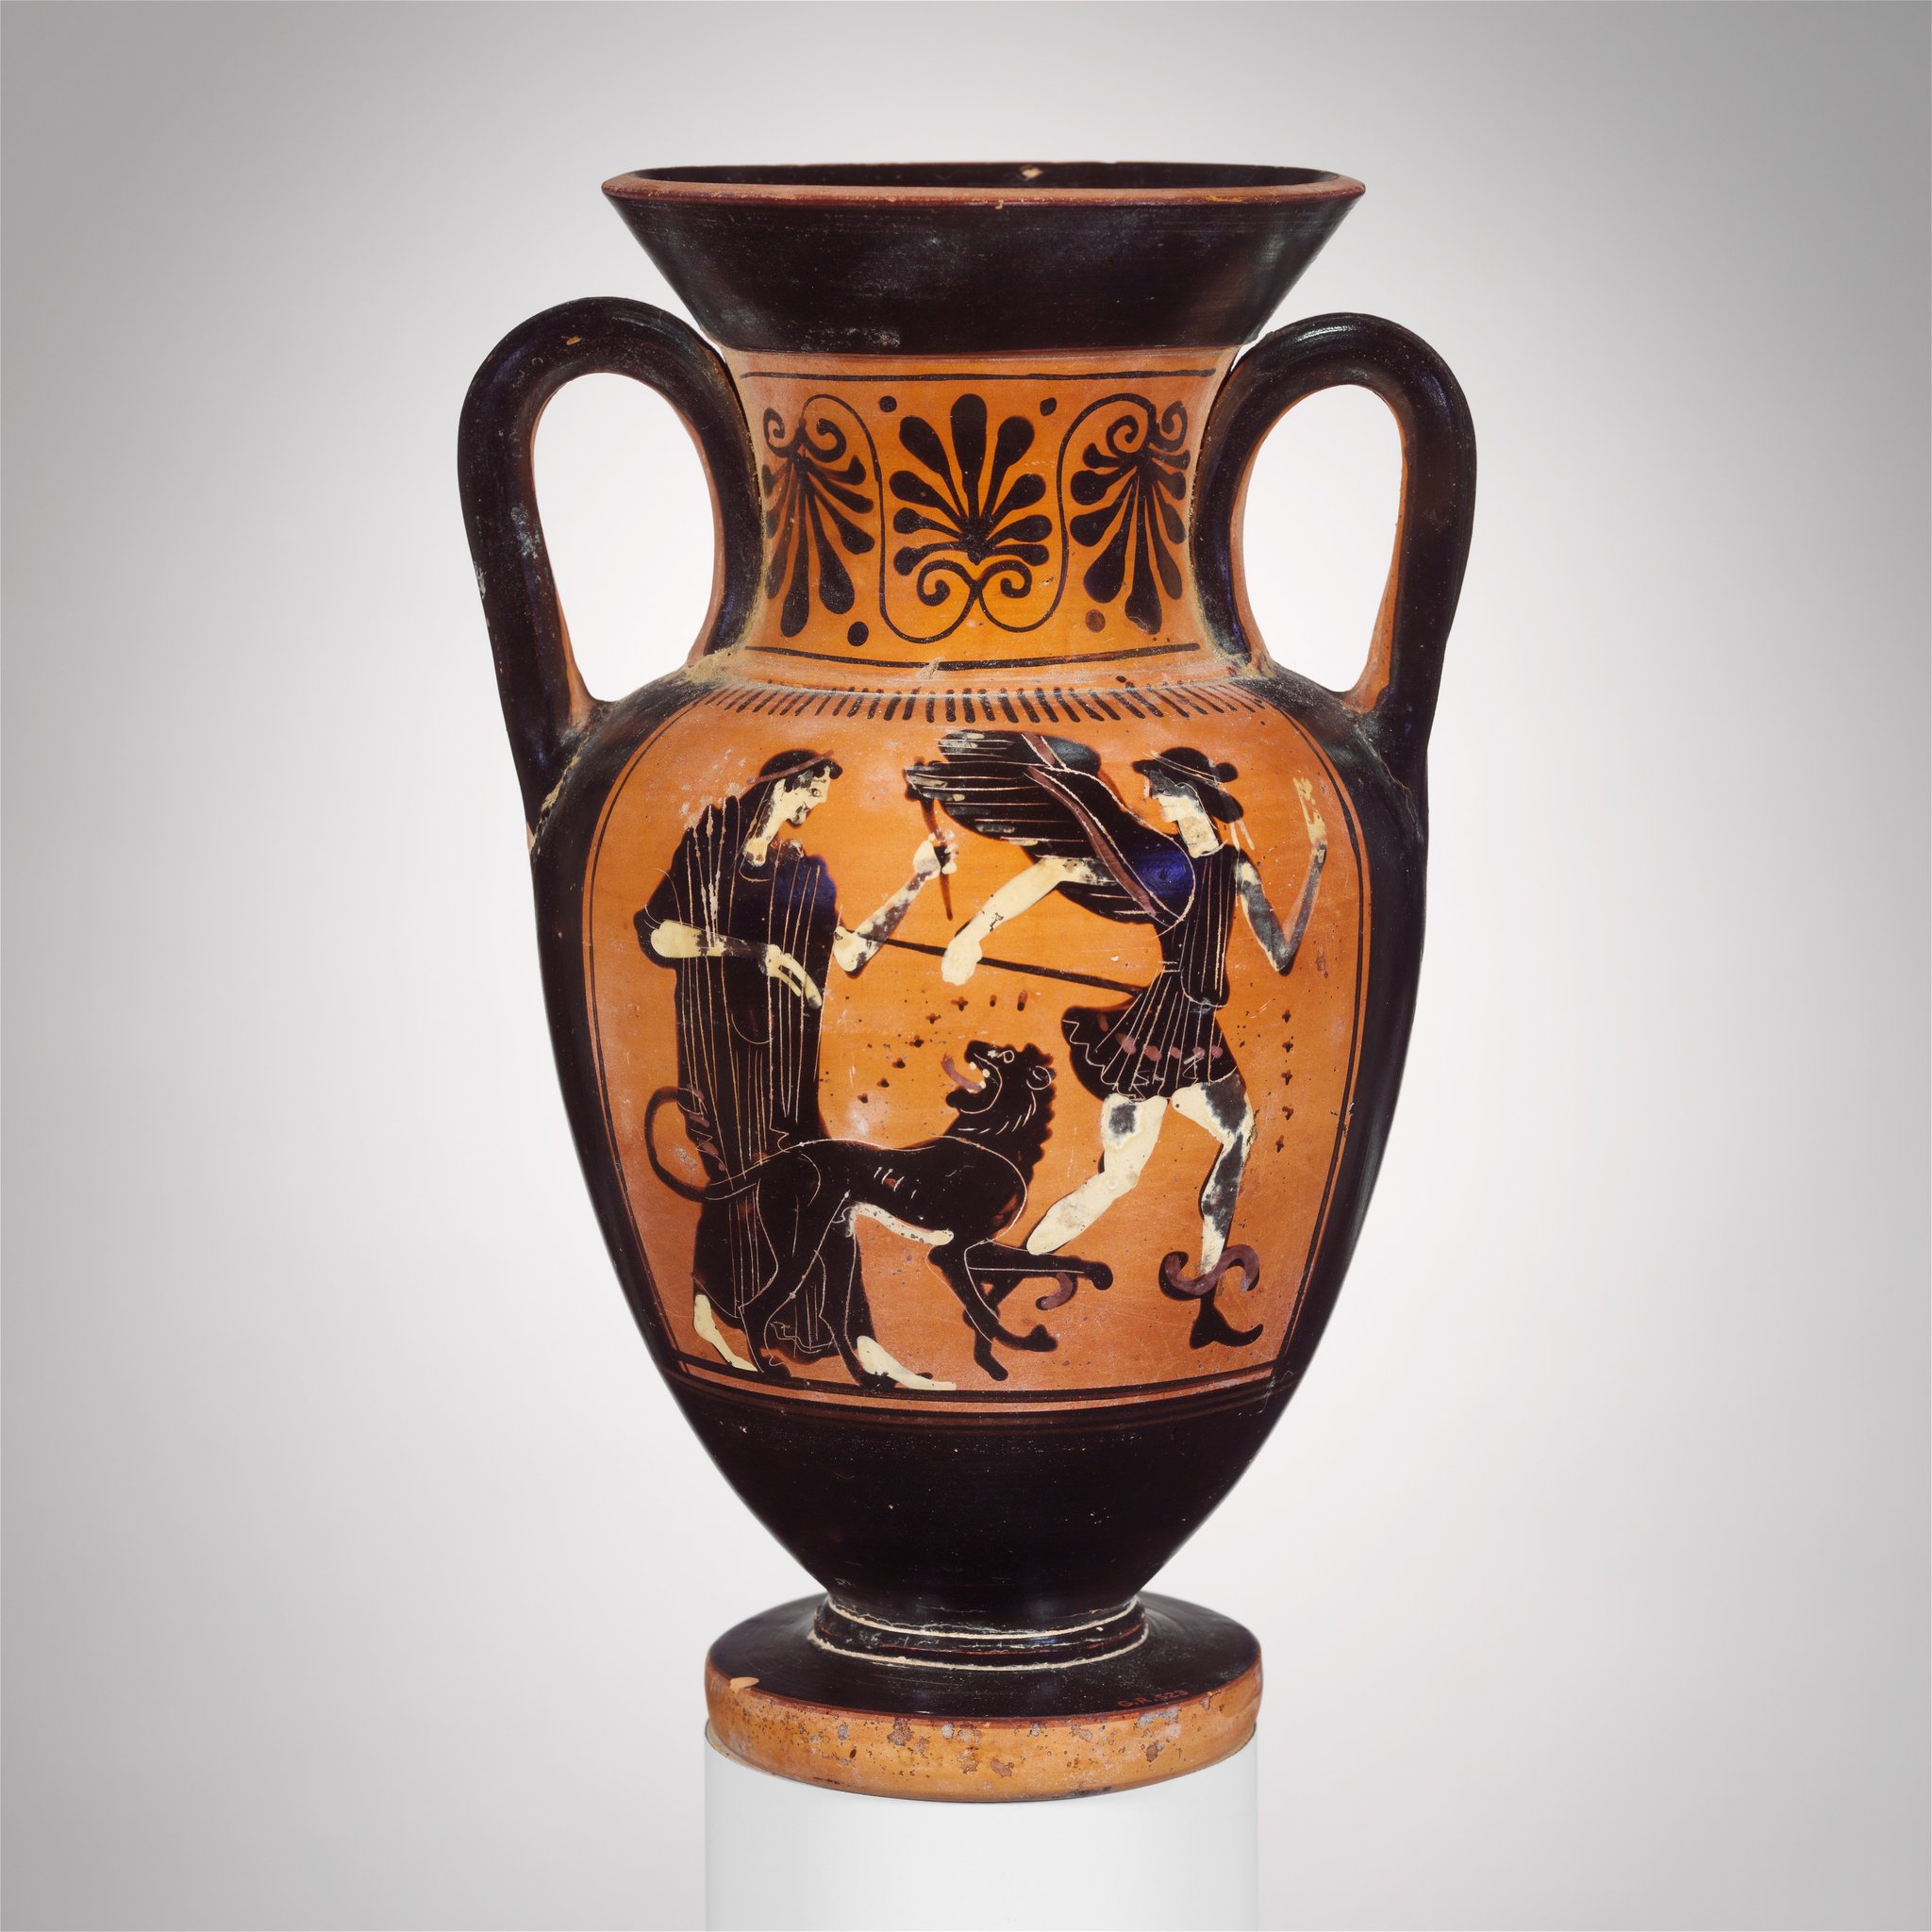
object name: neck amphora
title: Terracotta neck-amphora (jar)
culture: greek, attic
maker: diosphos painter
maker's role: artist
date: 500 BCE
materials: terracotta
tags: lions,herakles